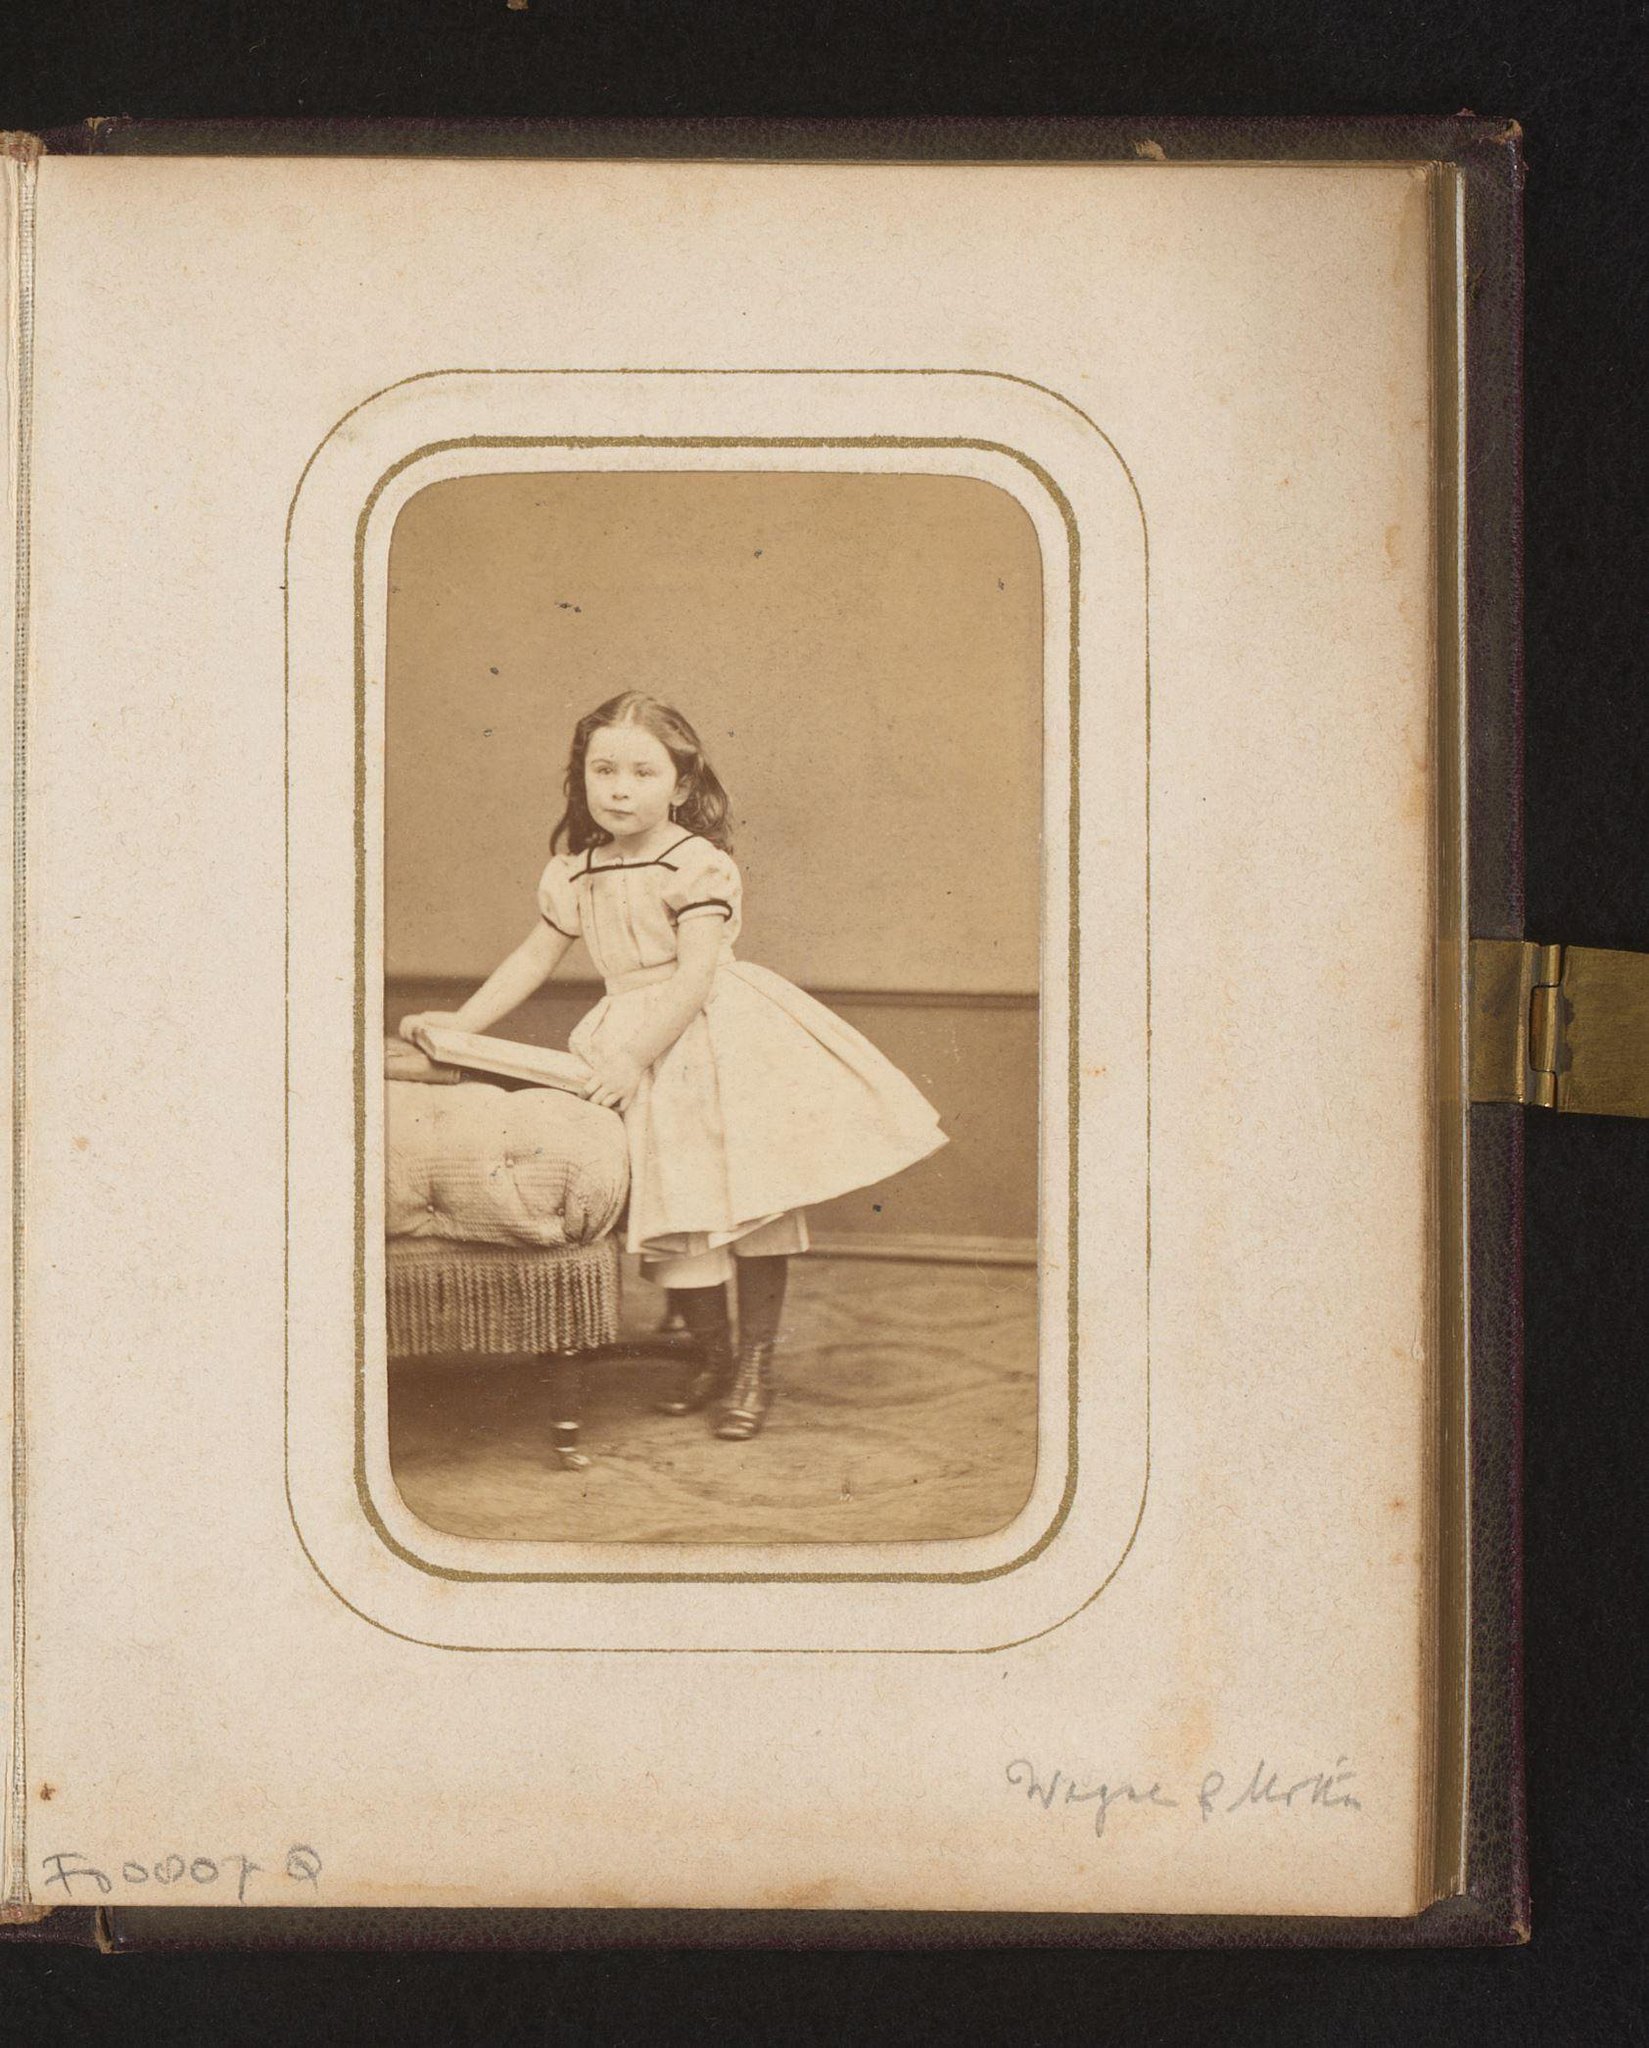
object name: photograph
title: Portret van een meisje staand bij een divan met boeken, aangeduid als Elise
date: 1865-1900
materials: cardboard, photographic support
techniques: albumen print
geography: amsterdam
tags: historical persons - bb - woman, girl (child between toddler and youth), book, couch, sofa, settee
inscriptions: dedication: ‘À mon cher g[...] papa/ a la part de sa petite/ fille/ Elise’, inscription: ‘PHOTOGr ATELIER/ WEGNER & MOTTU,/ KALVERSTRAAT/ Over den Heyligenweg D. 26/ AMSTERDAM’, annotation: ‘Wegner & Mottu’